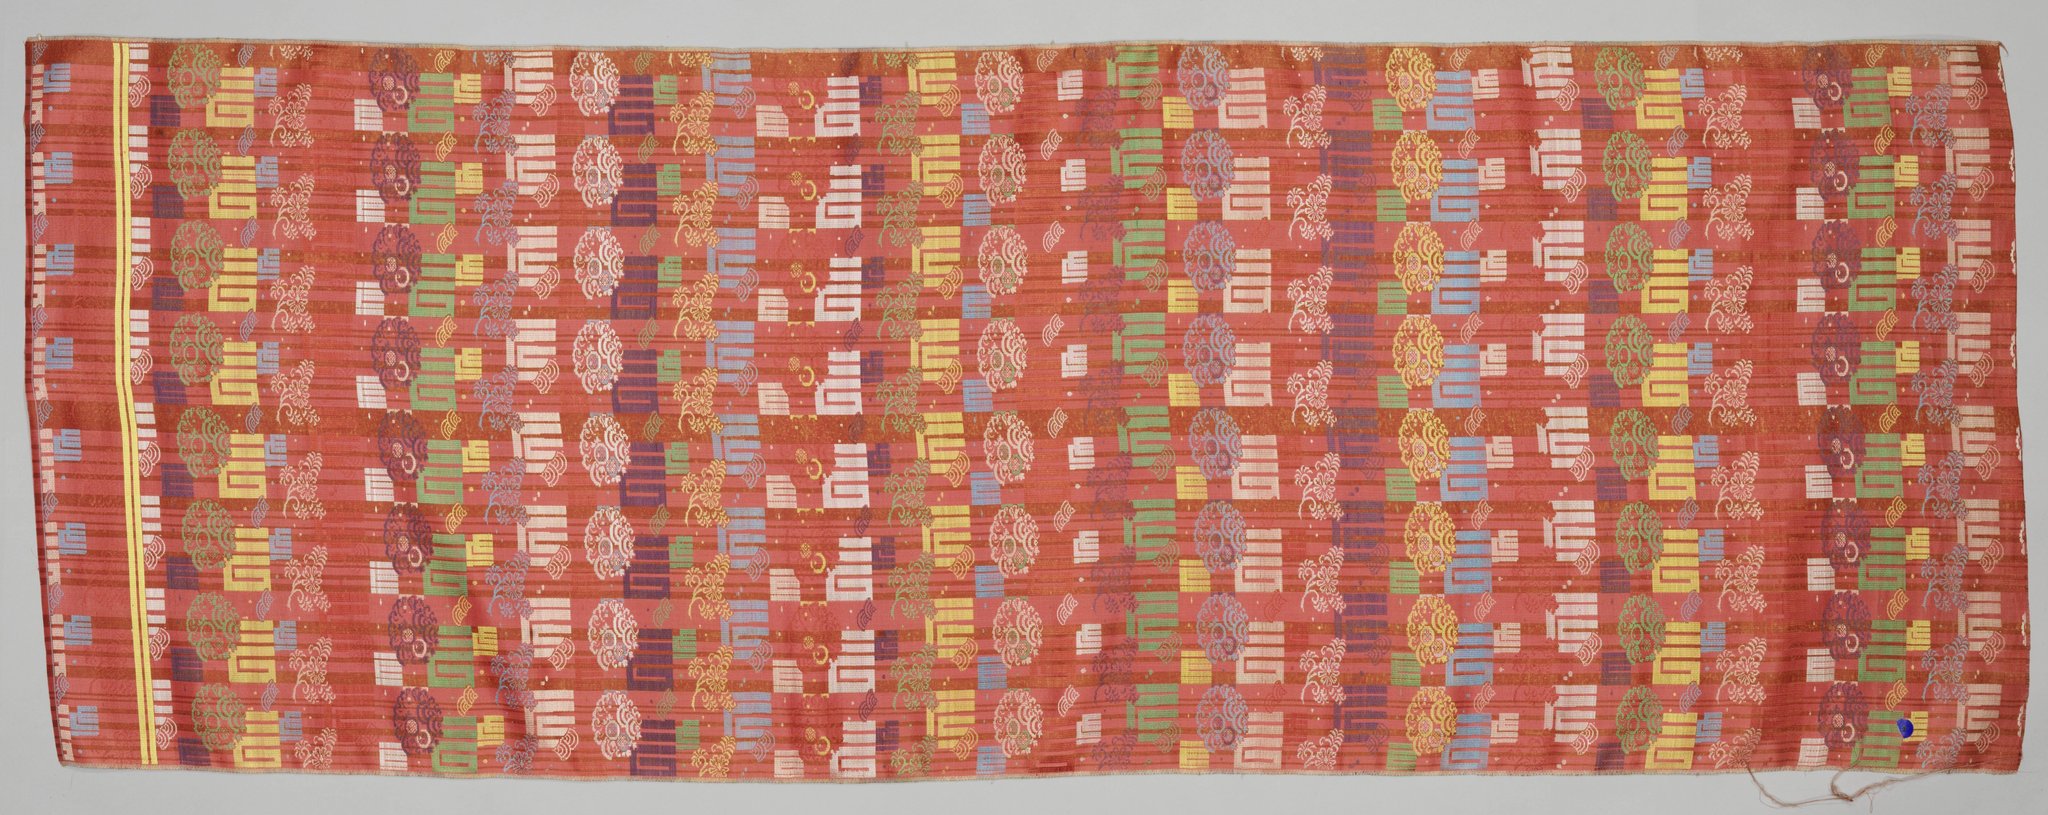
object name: textile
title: Baan zijde met een dessin van smalle en bredere strepen met ingeweven bloemen waarover een dessin van geometrische vormen, ovale florale vormen, waaiers, bloemen en weer waaiers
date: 1900-1920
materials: silk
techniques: weave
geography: japan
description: Baan zijde met een dessin van smalle en bredere strepen in felroze en oranjerood grondweefsel met ingeweven rode bloemen, "waaroverheen" een dessin van geometrische vormen, ovale florale vormen, waaiers, bloemen en waaiers, in paars, blauw, geel, wit, groen en geel. Oosterse textiel.